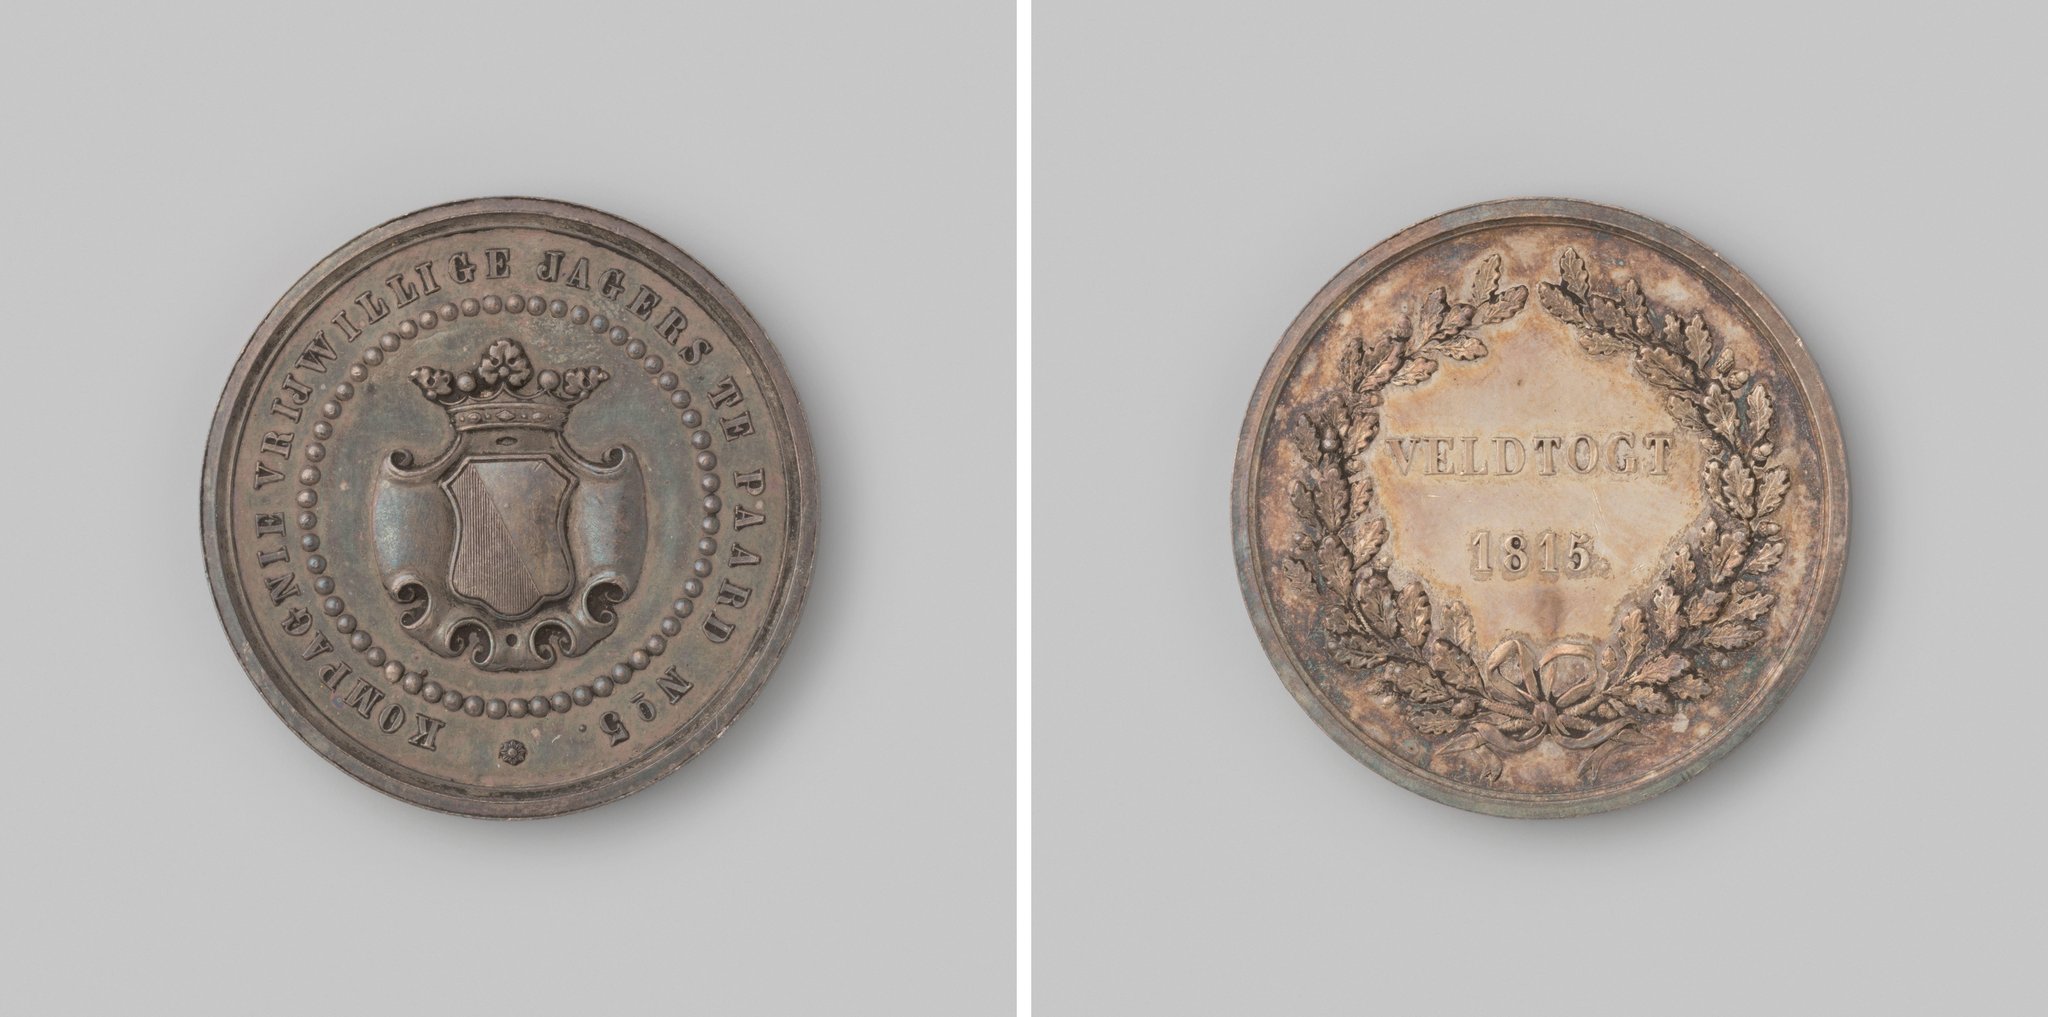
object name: ereteken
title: Compagnie vrijwillige jagers te paard, no. 5. te Utrecht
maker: Anonymous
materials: bronze